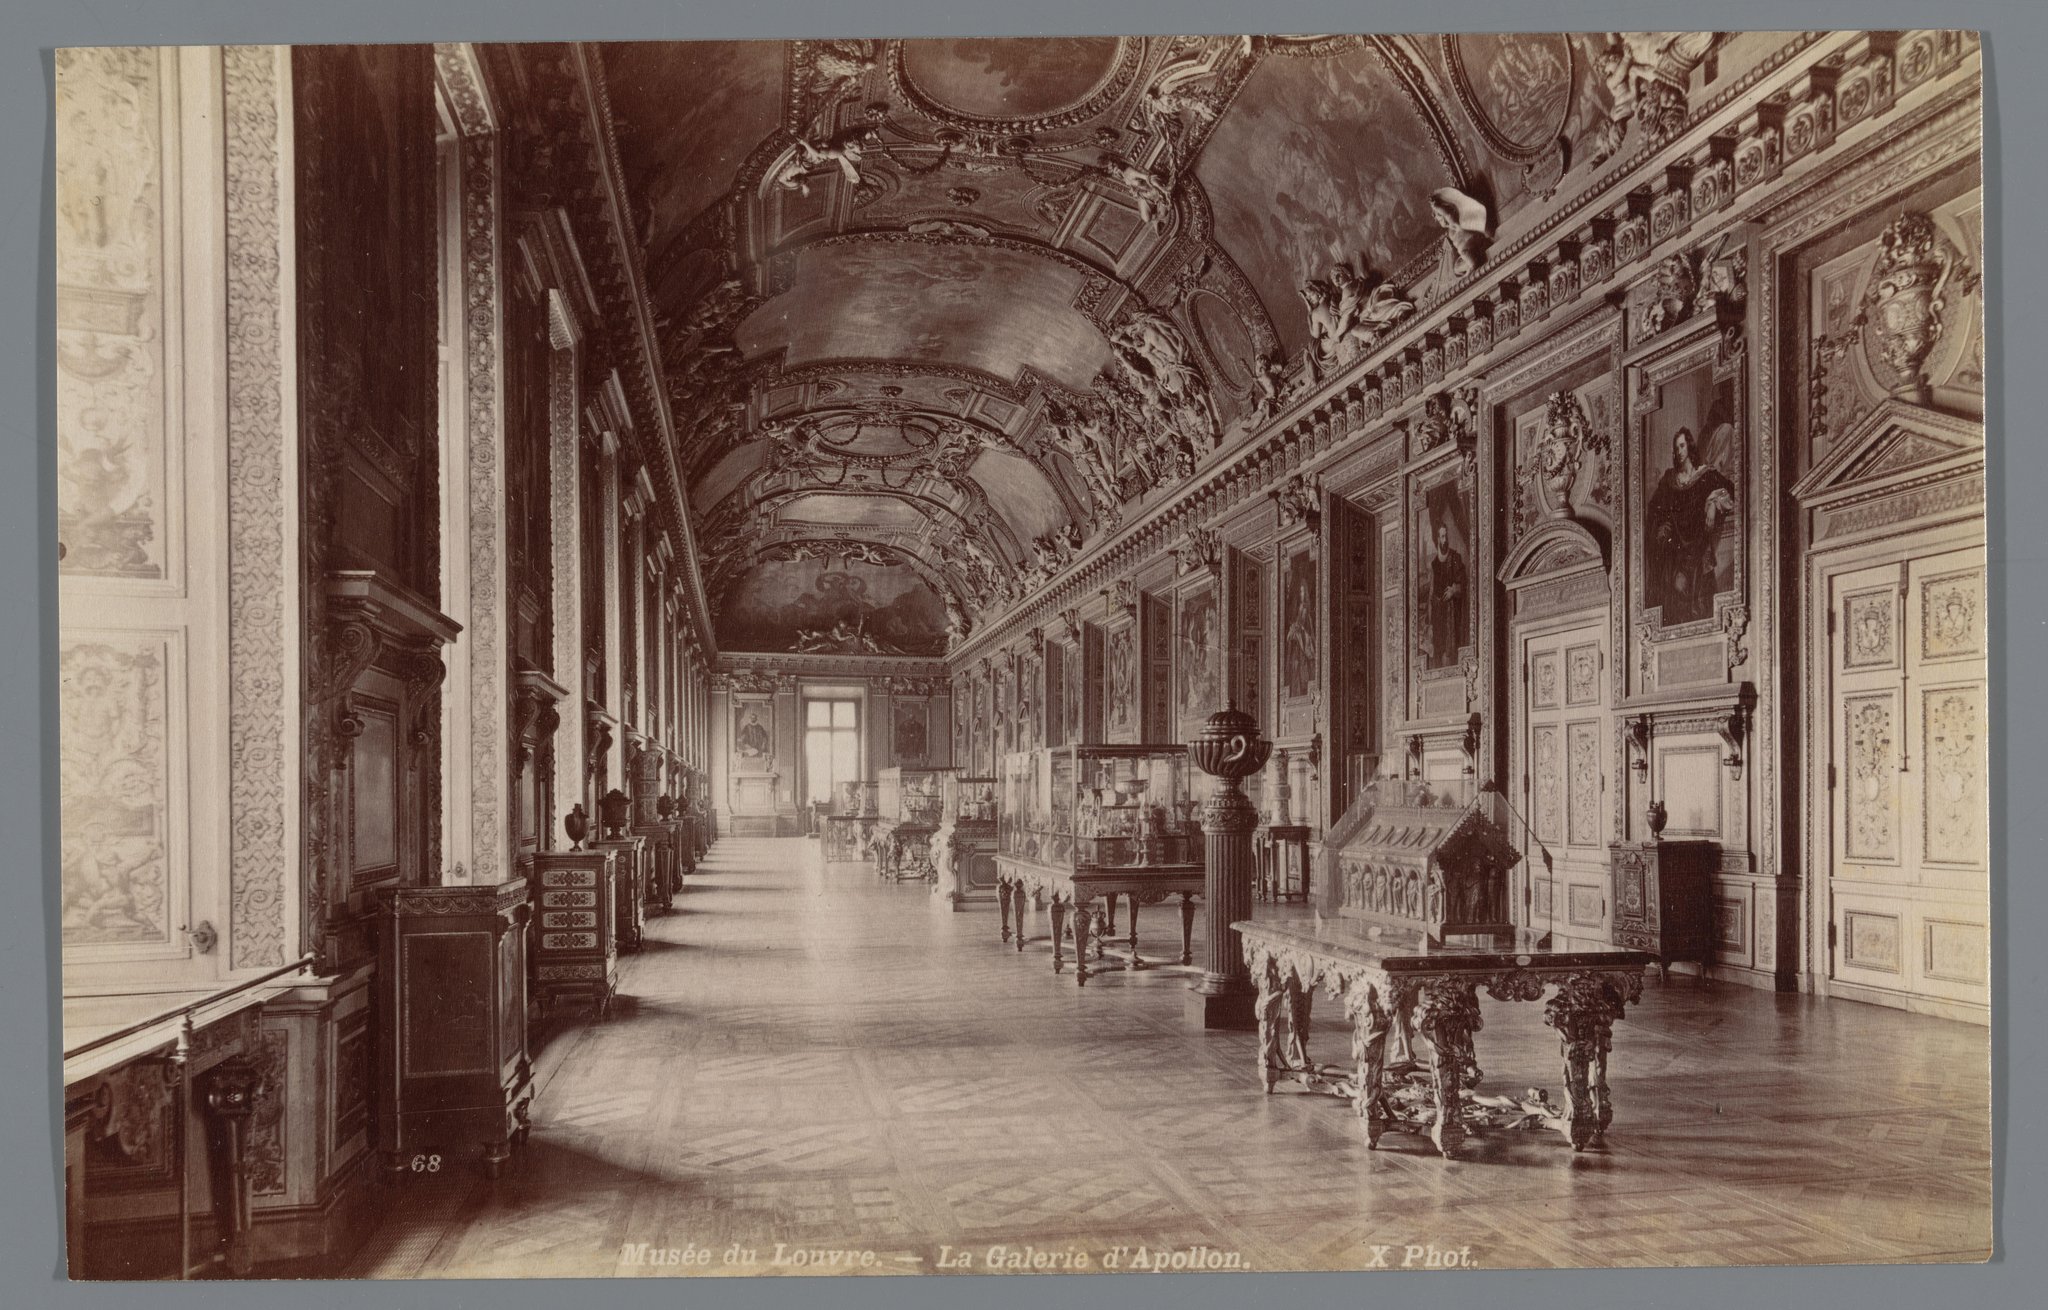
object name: photograph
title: Musée du Louvre.- La Galerie d'Apollon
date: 1887-1900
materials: paper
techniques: albumen print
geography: louvre museum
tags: gallery (spacious corridor), permanent exhibition, museum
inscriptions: number: ‘68’, number: ‘IIII’